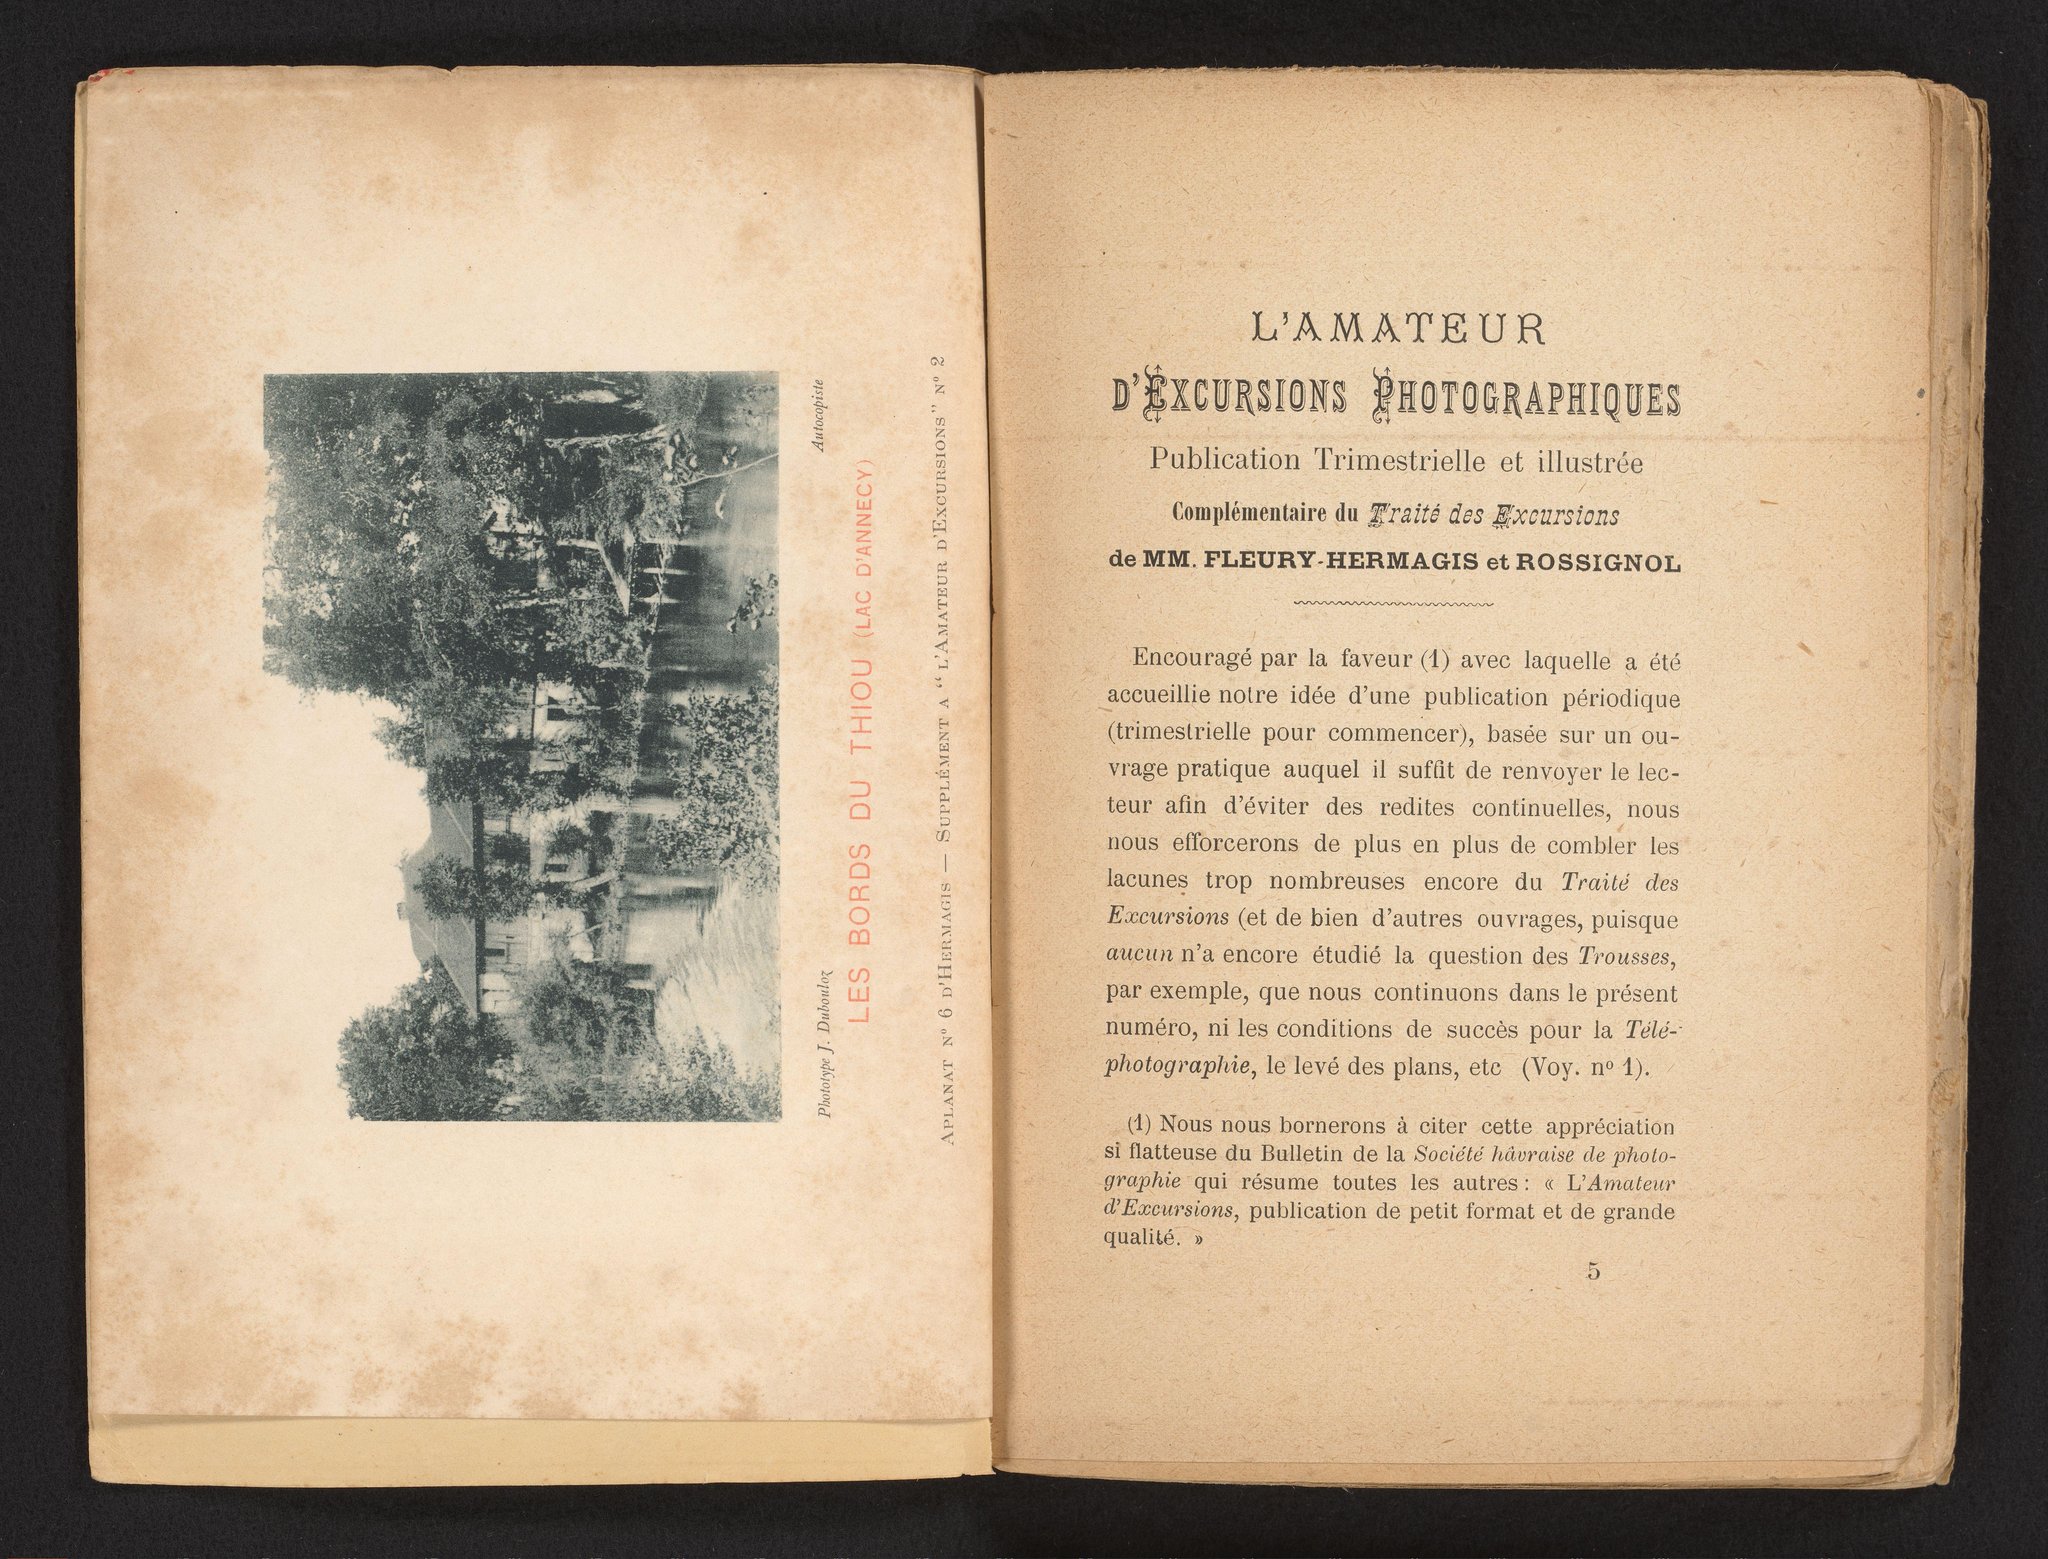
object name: book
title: L'amateur d'excursions photographiques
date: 1804-1896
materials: cardboard, paper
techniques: photograph, printing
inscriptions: date: ‘JUNE 1990’, annotation: ‘P.A. 76- 11,-’